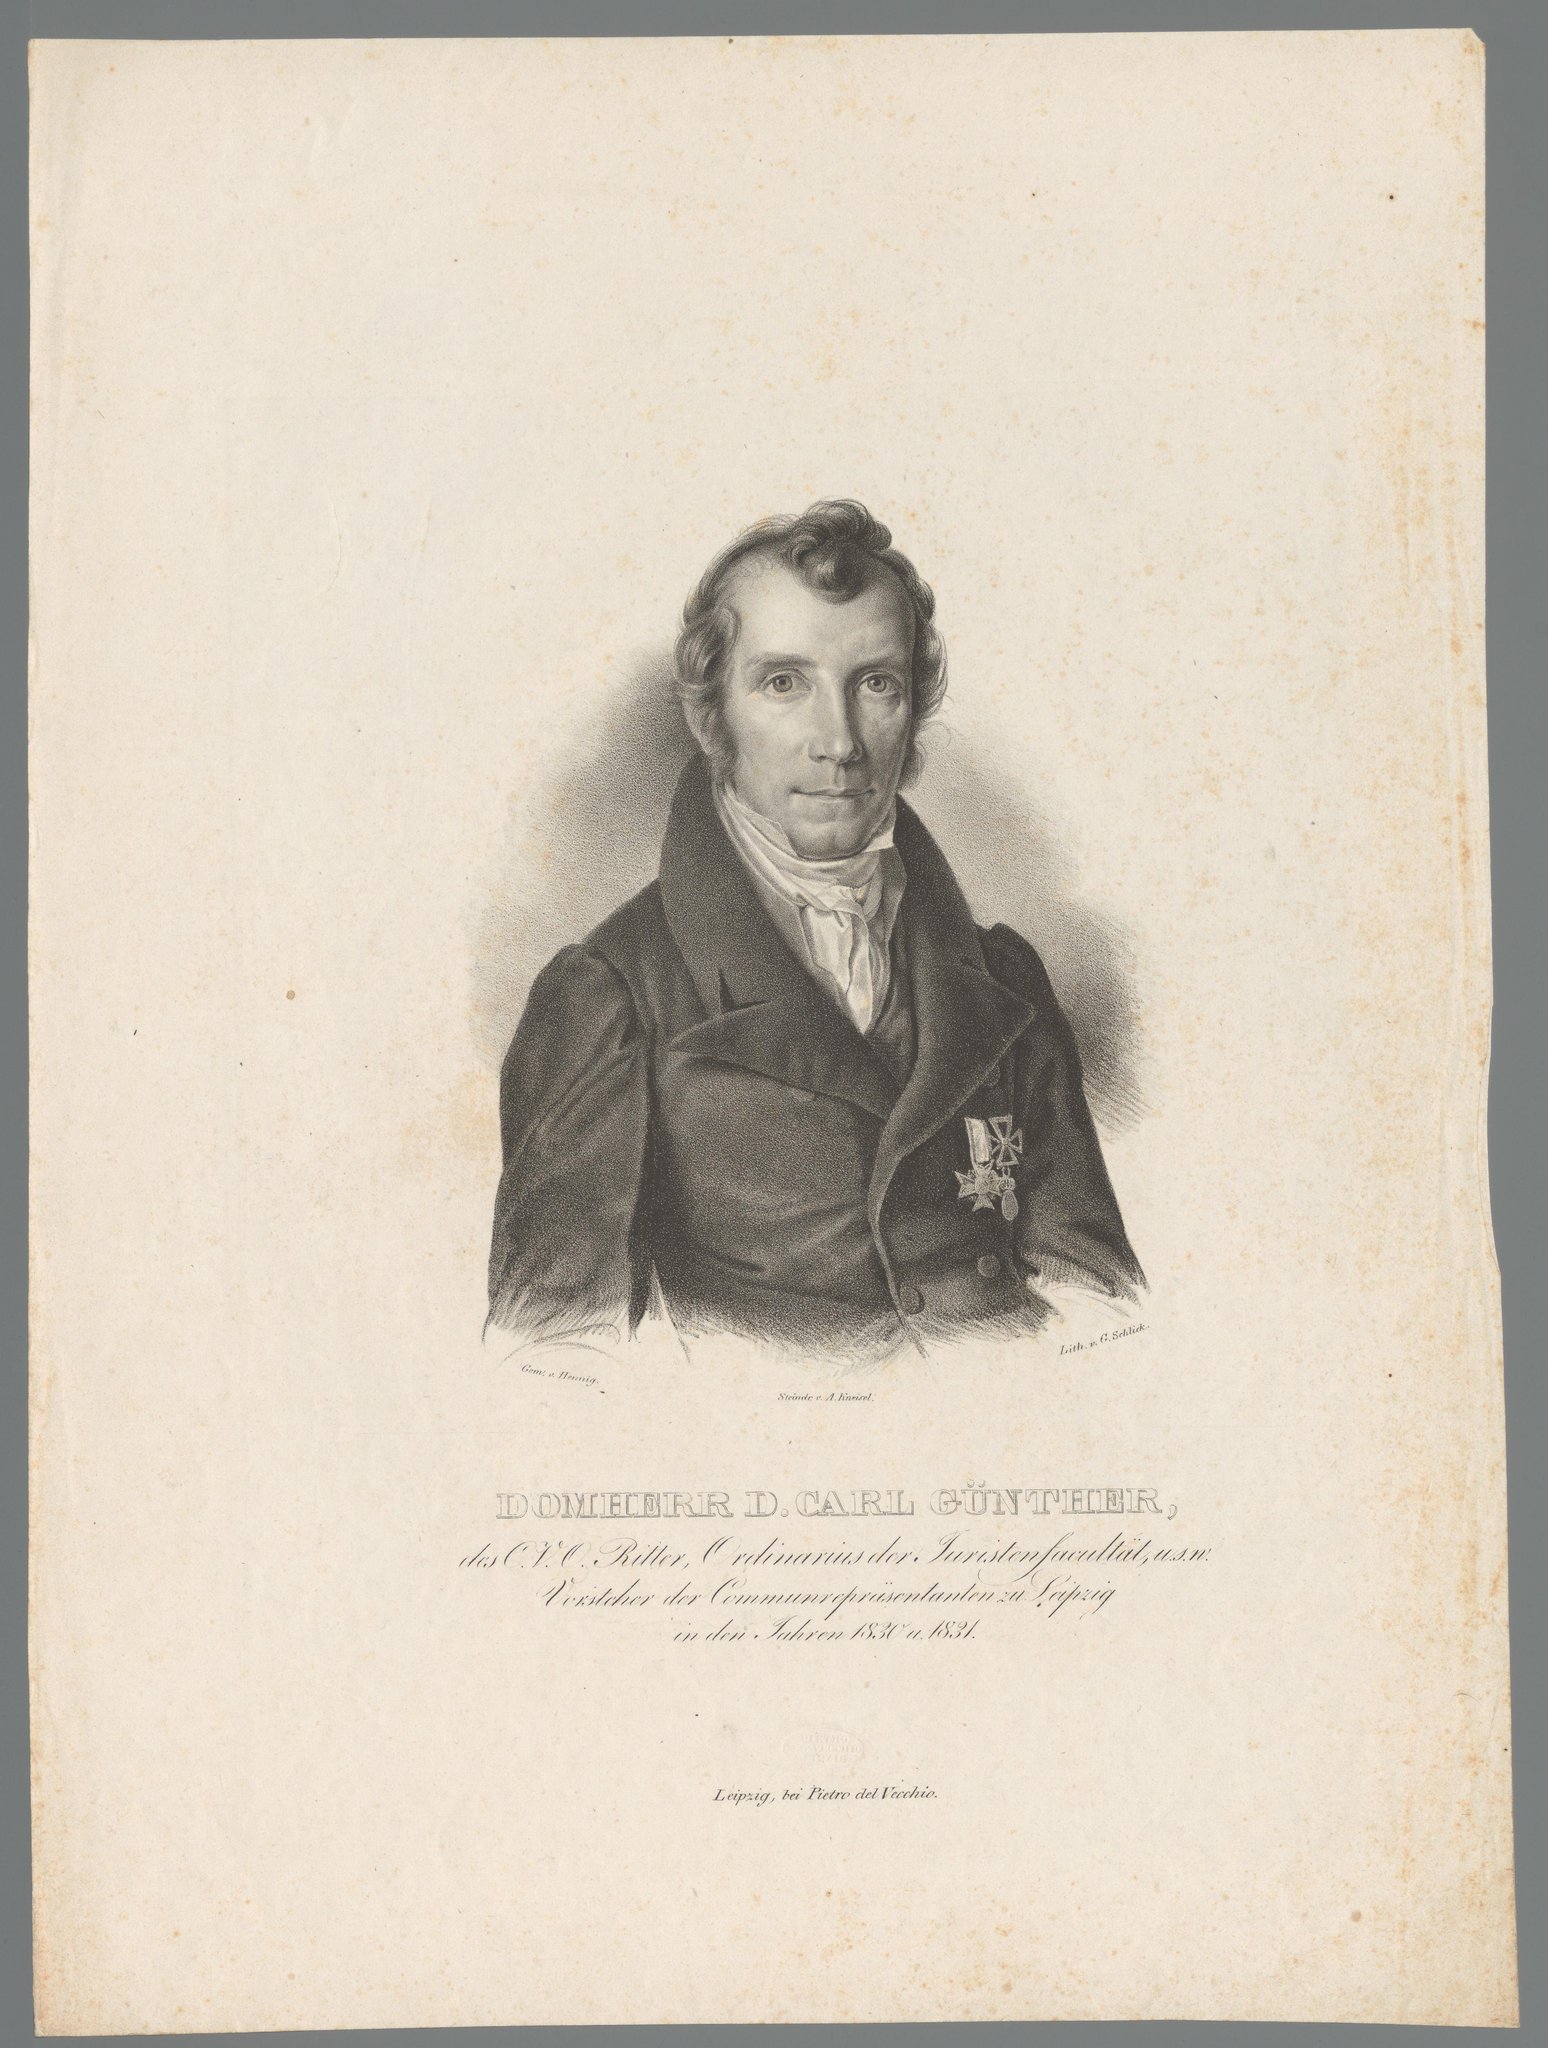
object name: print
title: Portret van Carl Fr. Günther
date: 1831-1855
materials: paper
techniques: lithograph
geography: leipzig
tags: politician, historical persons, politician, e.g. party leader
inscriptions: collector's mark: Lugt 2228, check stamp: ‘Pietro Del Vecchio Leipzig’